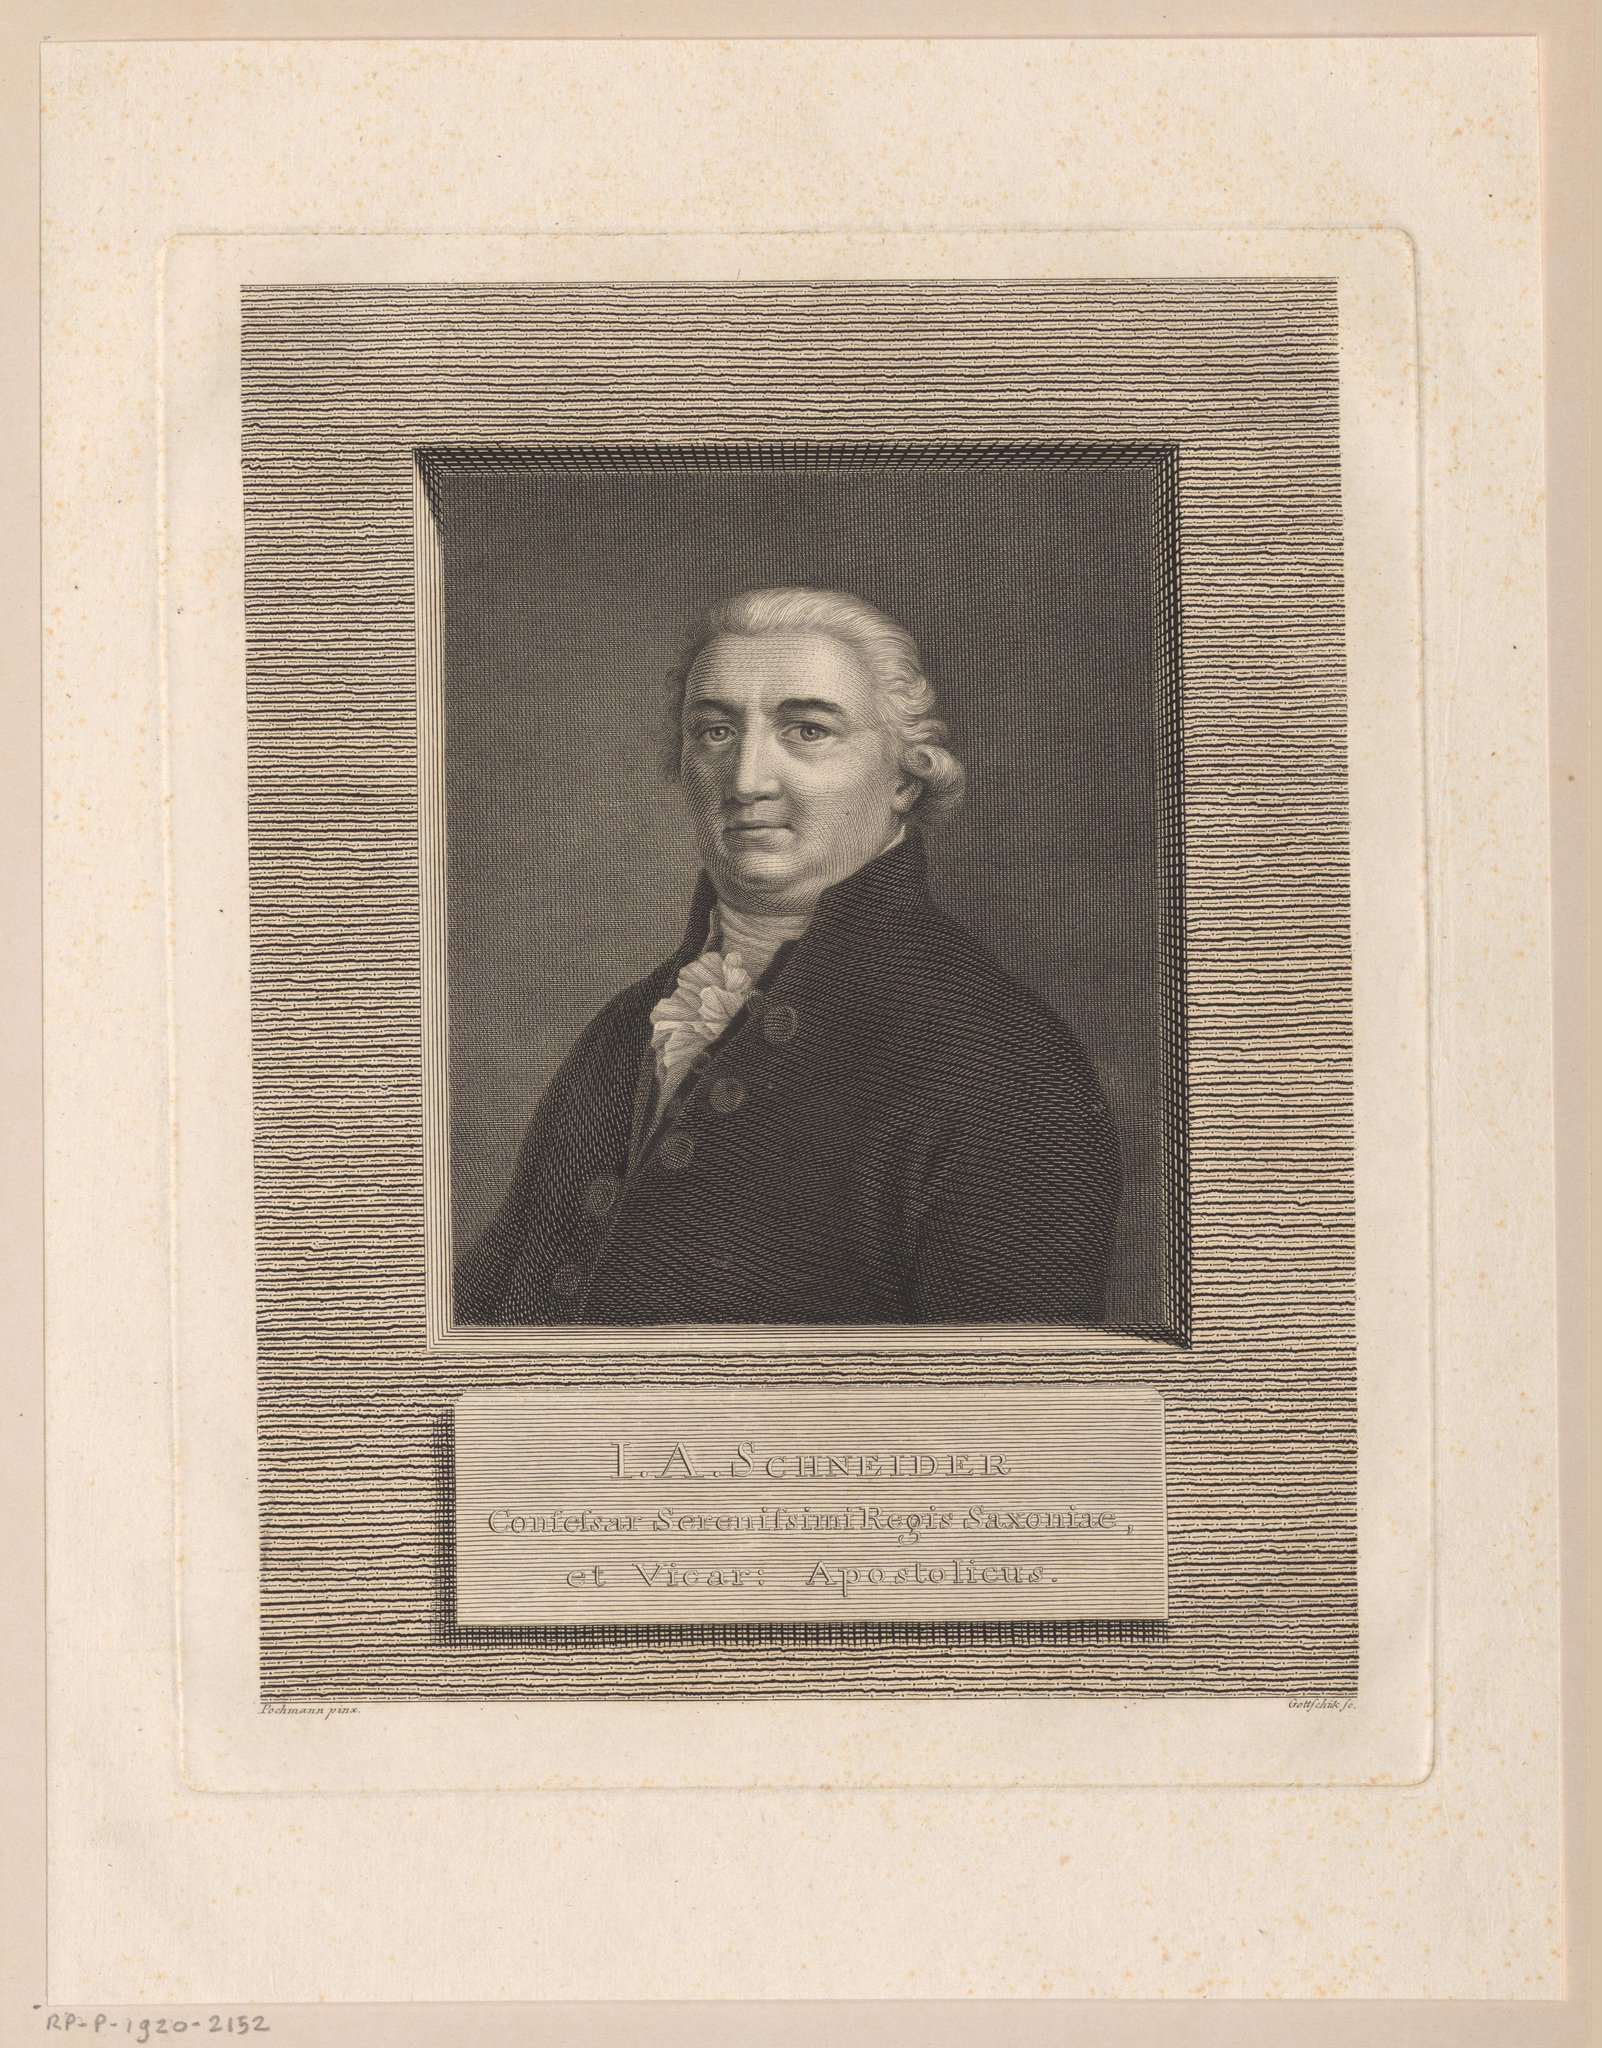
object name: print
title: Portret van Johann Aloys Schneider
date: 1801-1844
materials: paper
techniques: engraving, etching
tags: theologian, historical persons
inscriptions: collector's mark: Lugt 2228